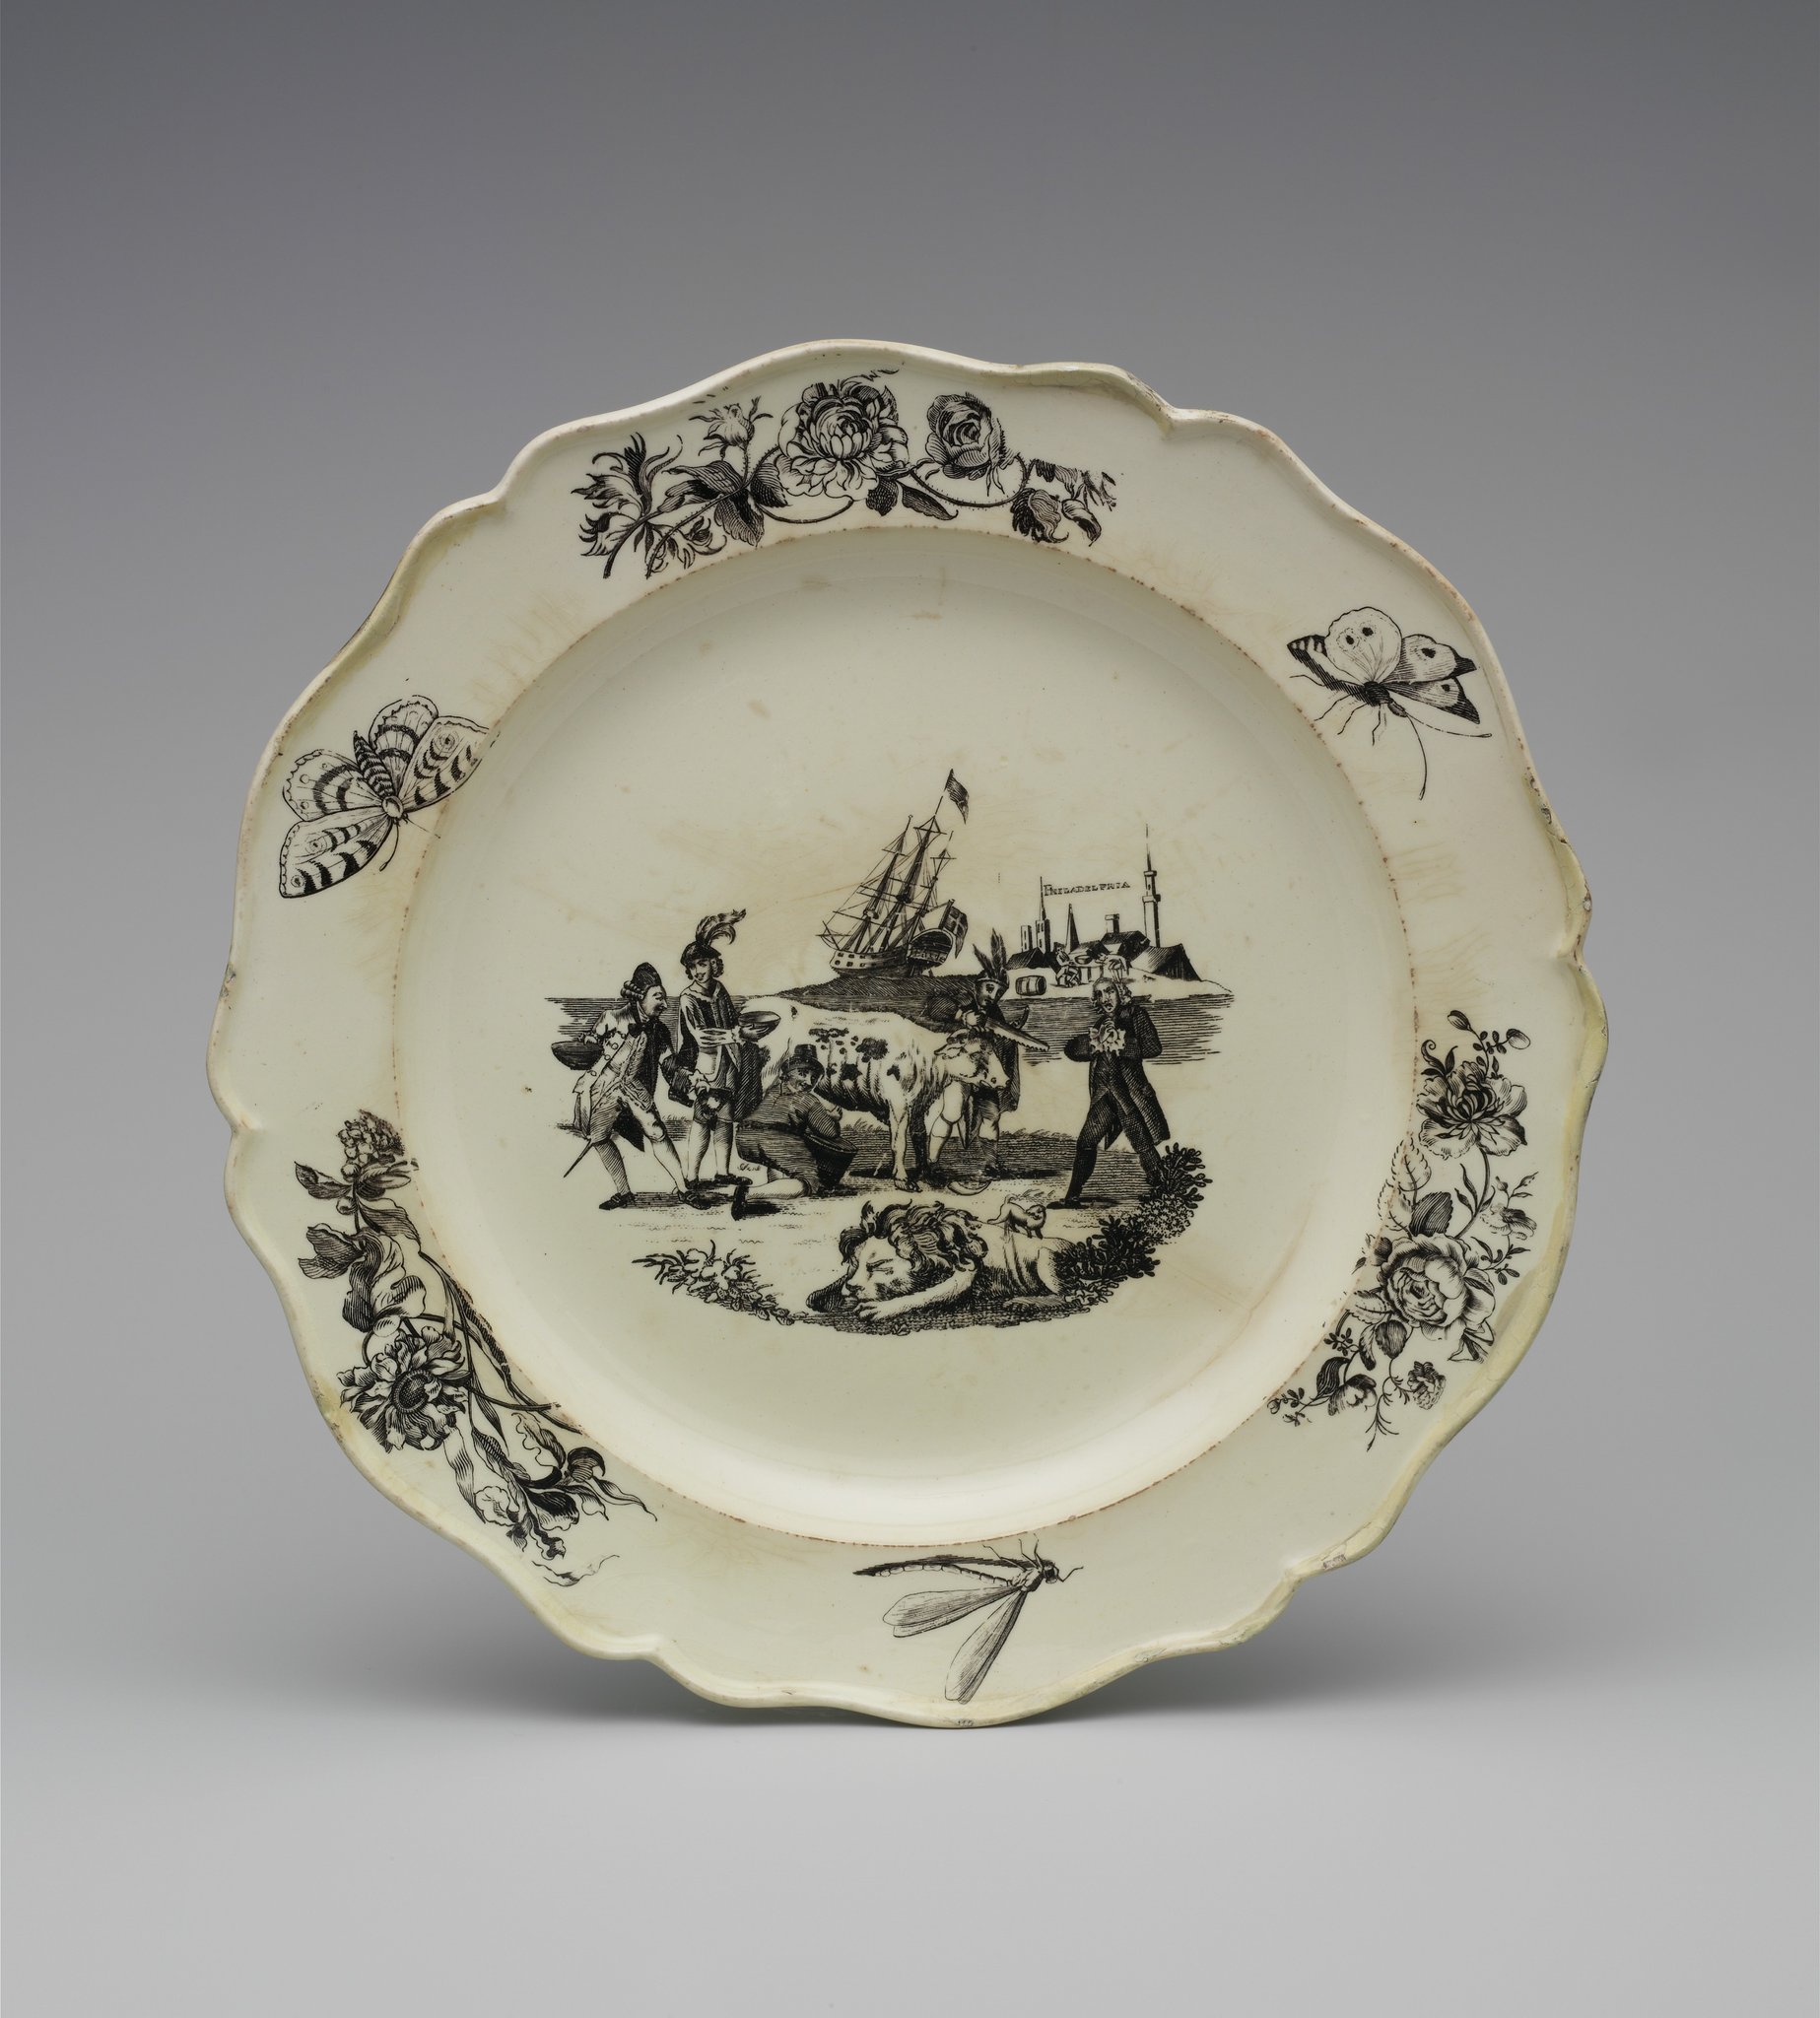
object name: plate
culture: british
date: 1778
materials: earthenware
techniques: transfer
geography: england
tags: men,cows,lions,ships